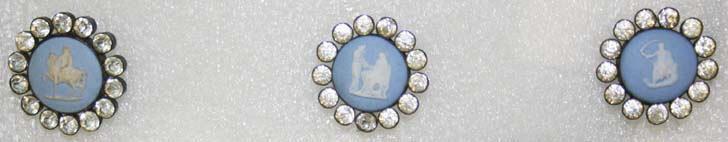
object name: button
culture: european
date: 1820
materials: metal, paste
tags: human figures,cameos,horses